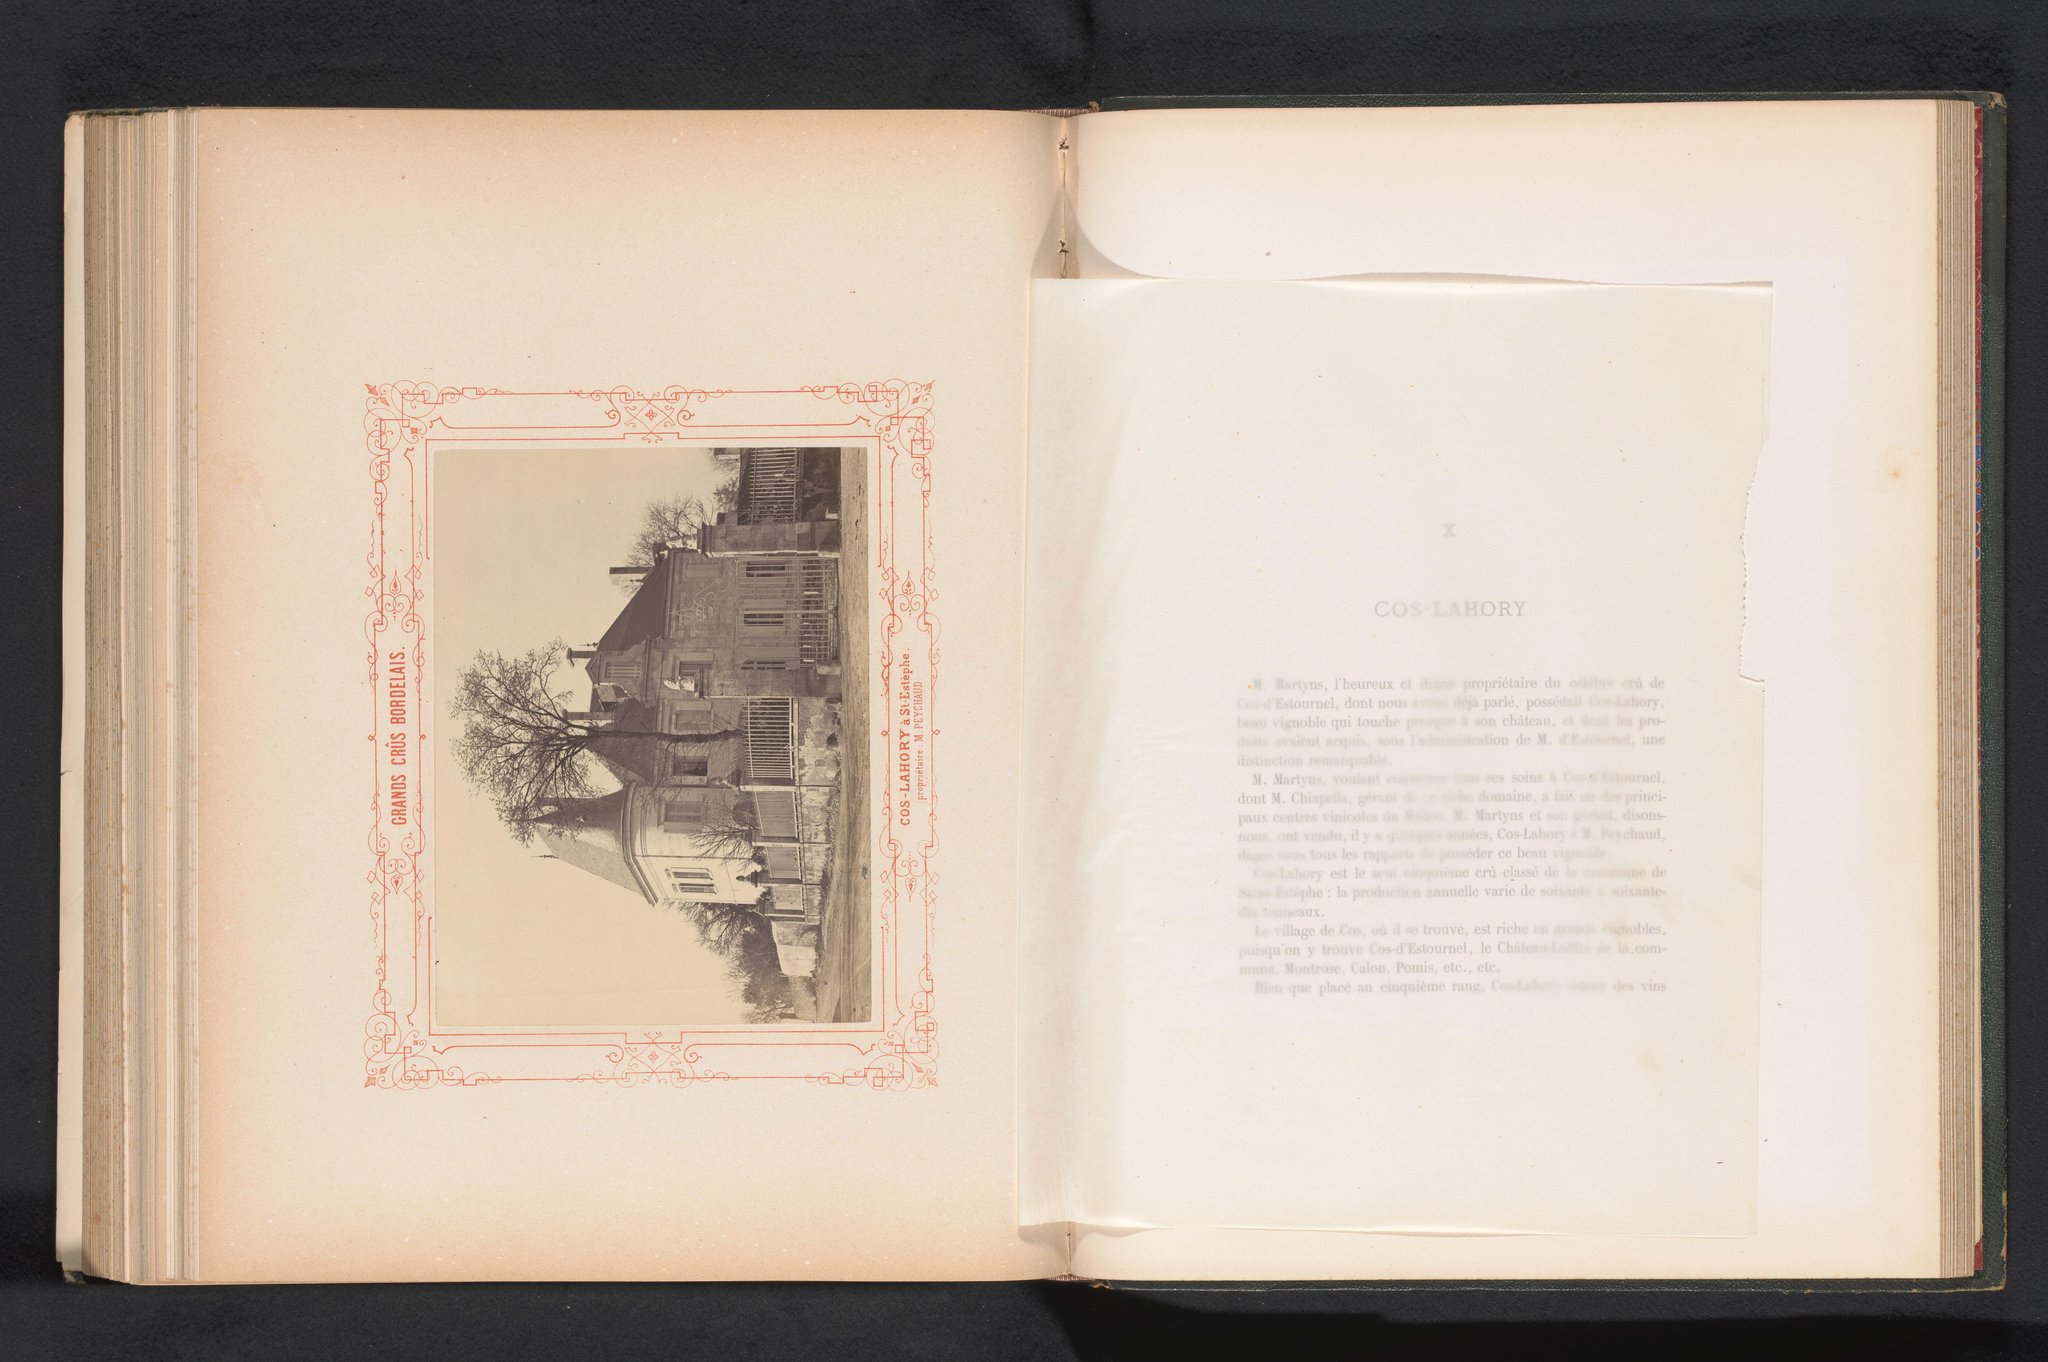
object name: photograph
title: Gezicht op Château Cos Labory in Saint-Estèphe, Frankrijk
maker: alfred danflou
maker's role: fotograaf, schrijver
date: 1862-1867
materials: photographic support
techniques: albumen print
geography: saint-estèphe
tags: castle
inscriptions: inscription: ‘Propriétaire: M. PEYCHAUD.’